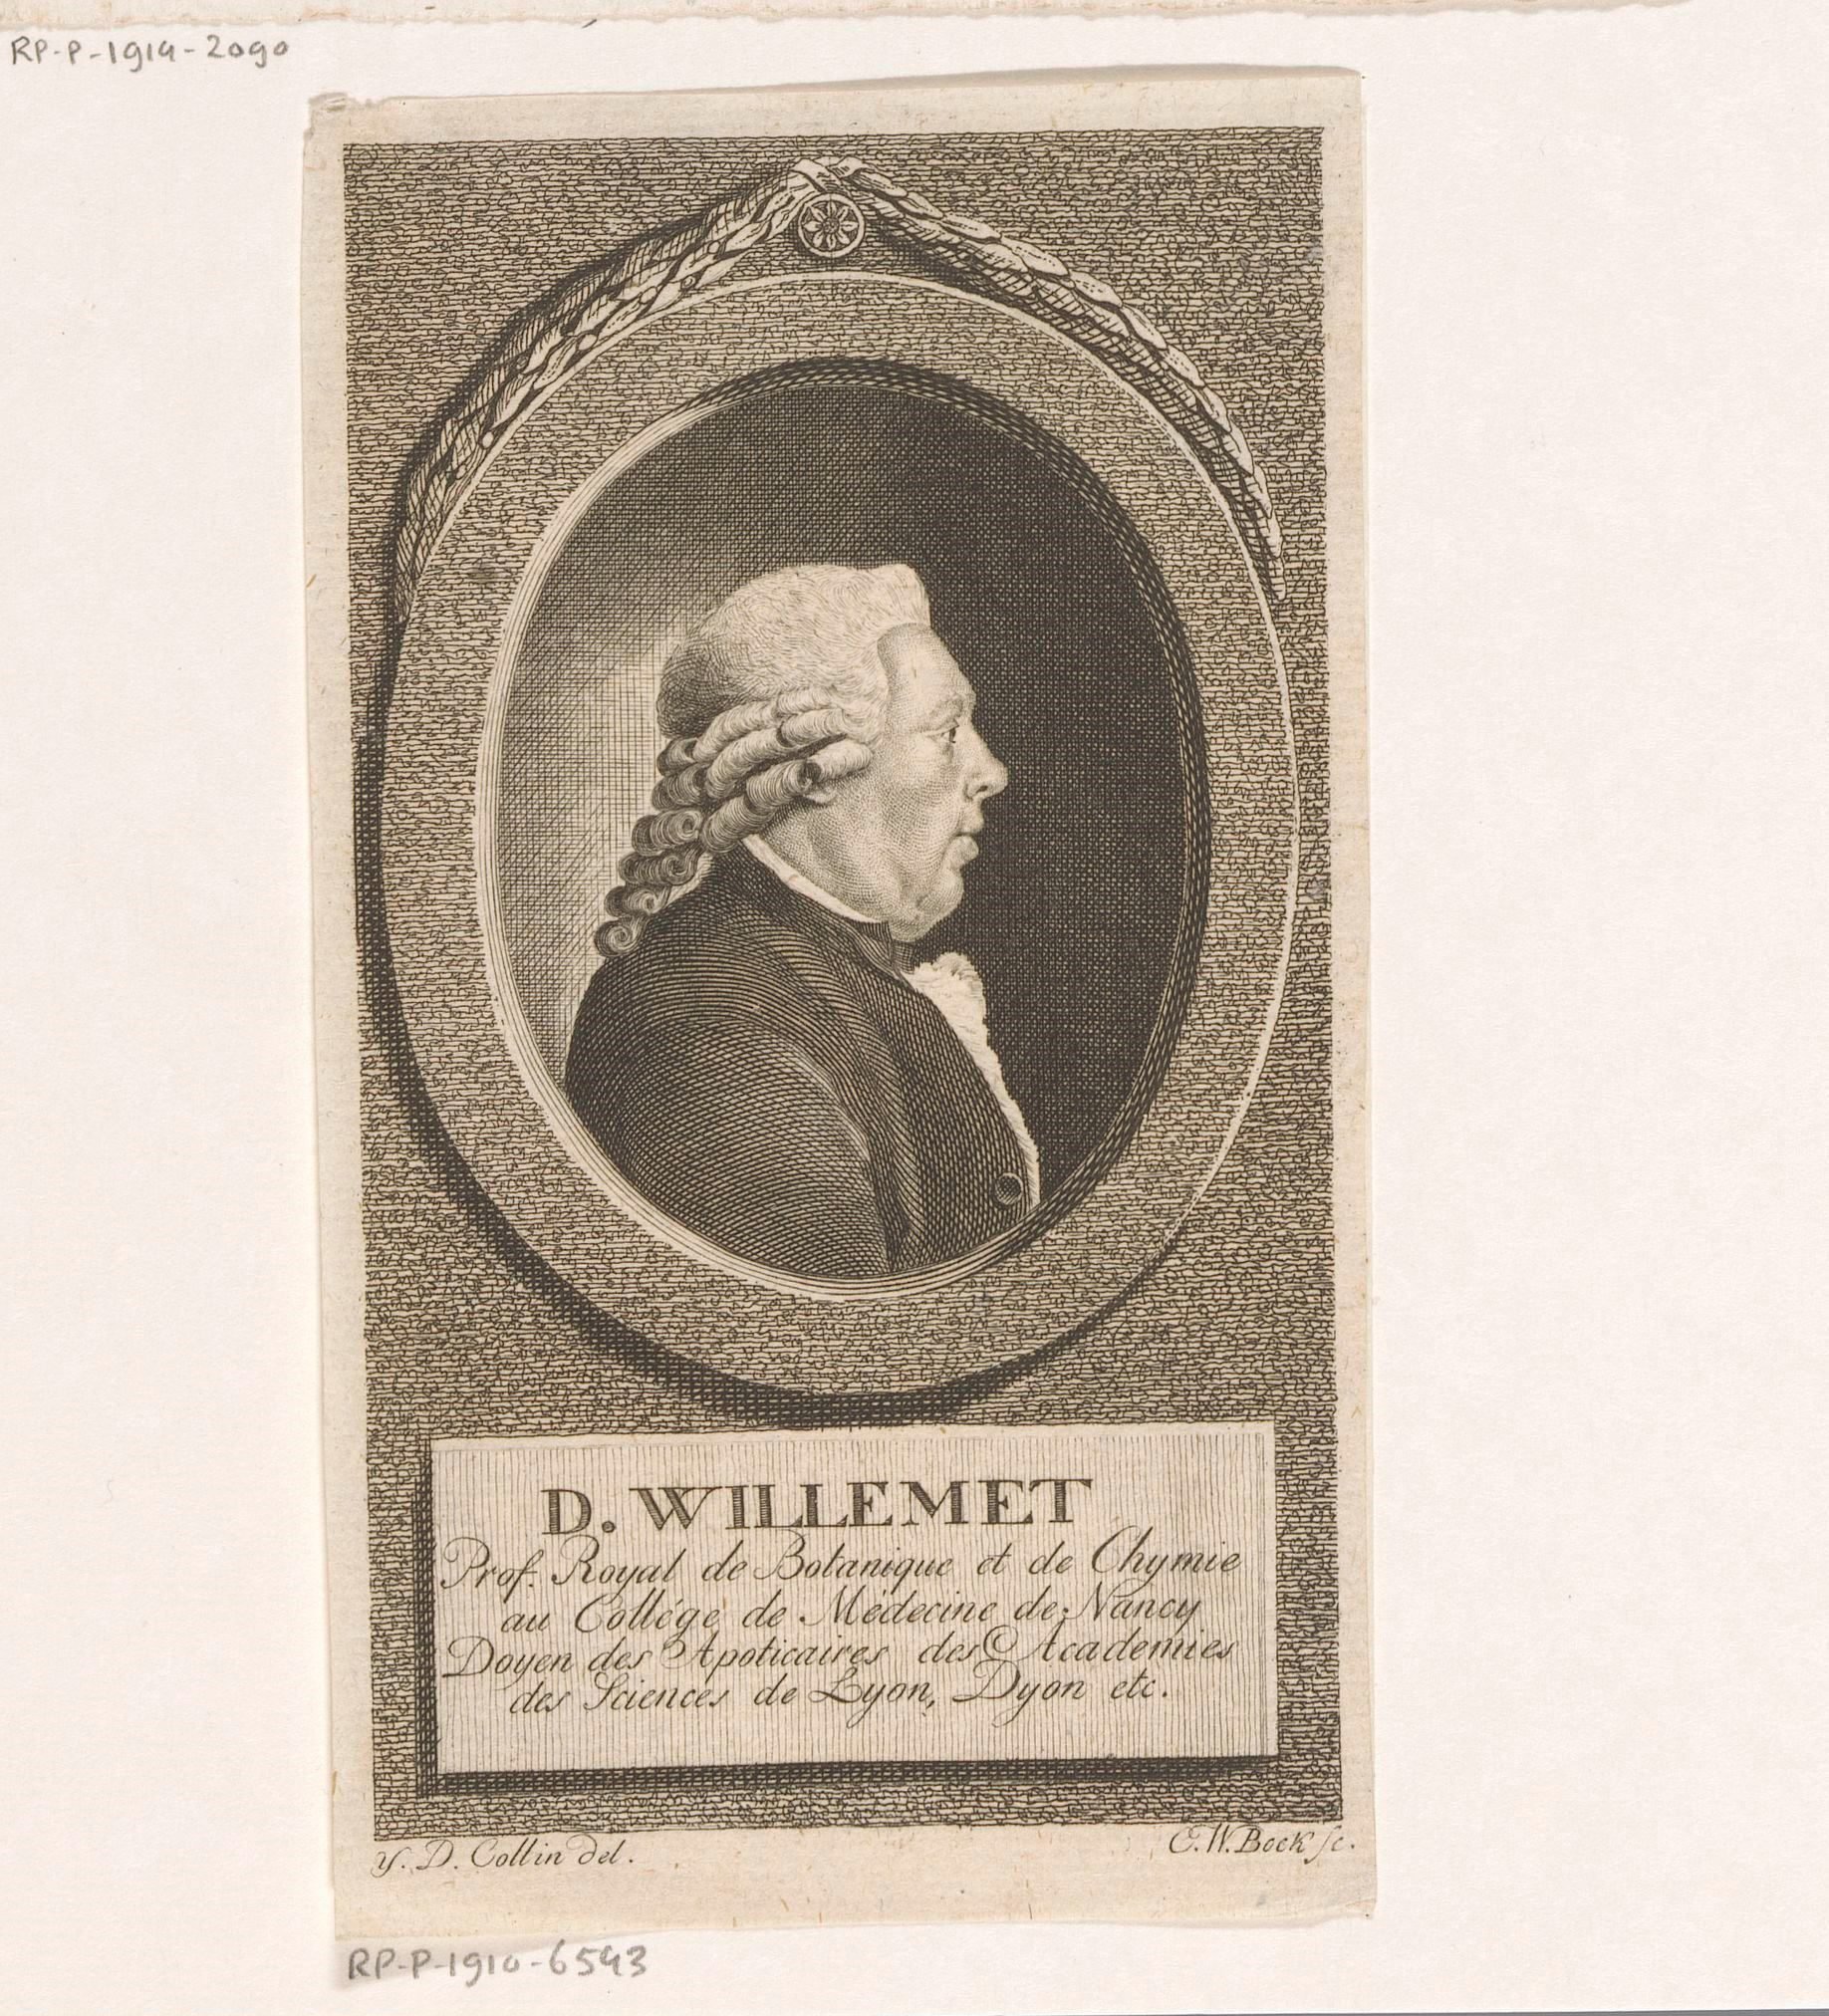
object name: print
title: Portret van Pierre Remi Willemet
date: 1765-1836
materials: paper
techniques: engraving, etching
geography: nuremberg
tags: france, historical persons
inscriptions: collector's mark: Lugt 2228